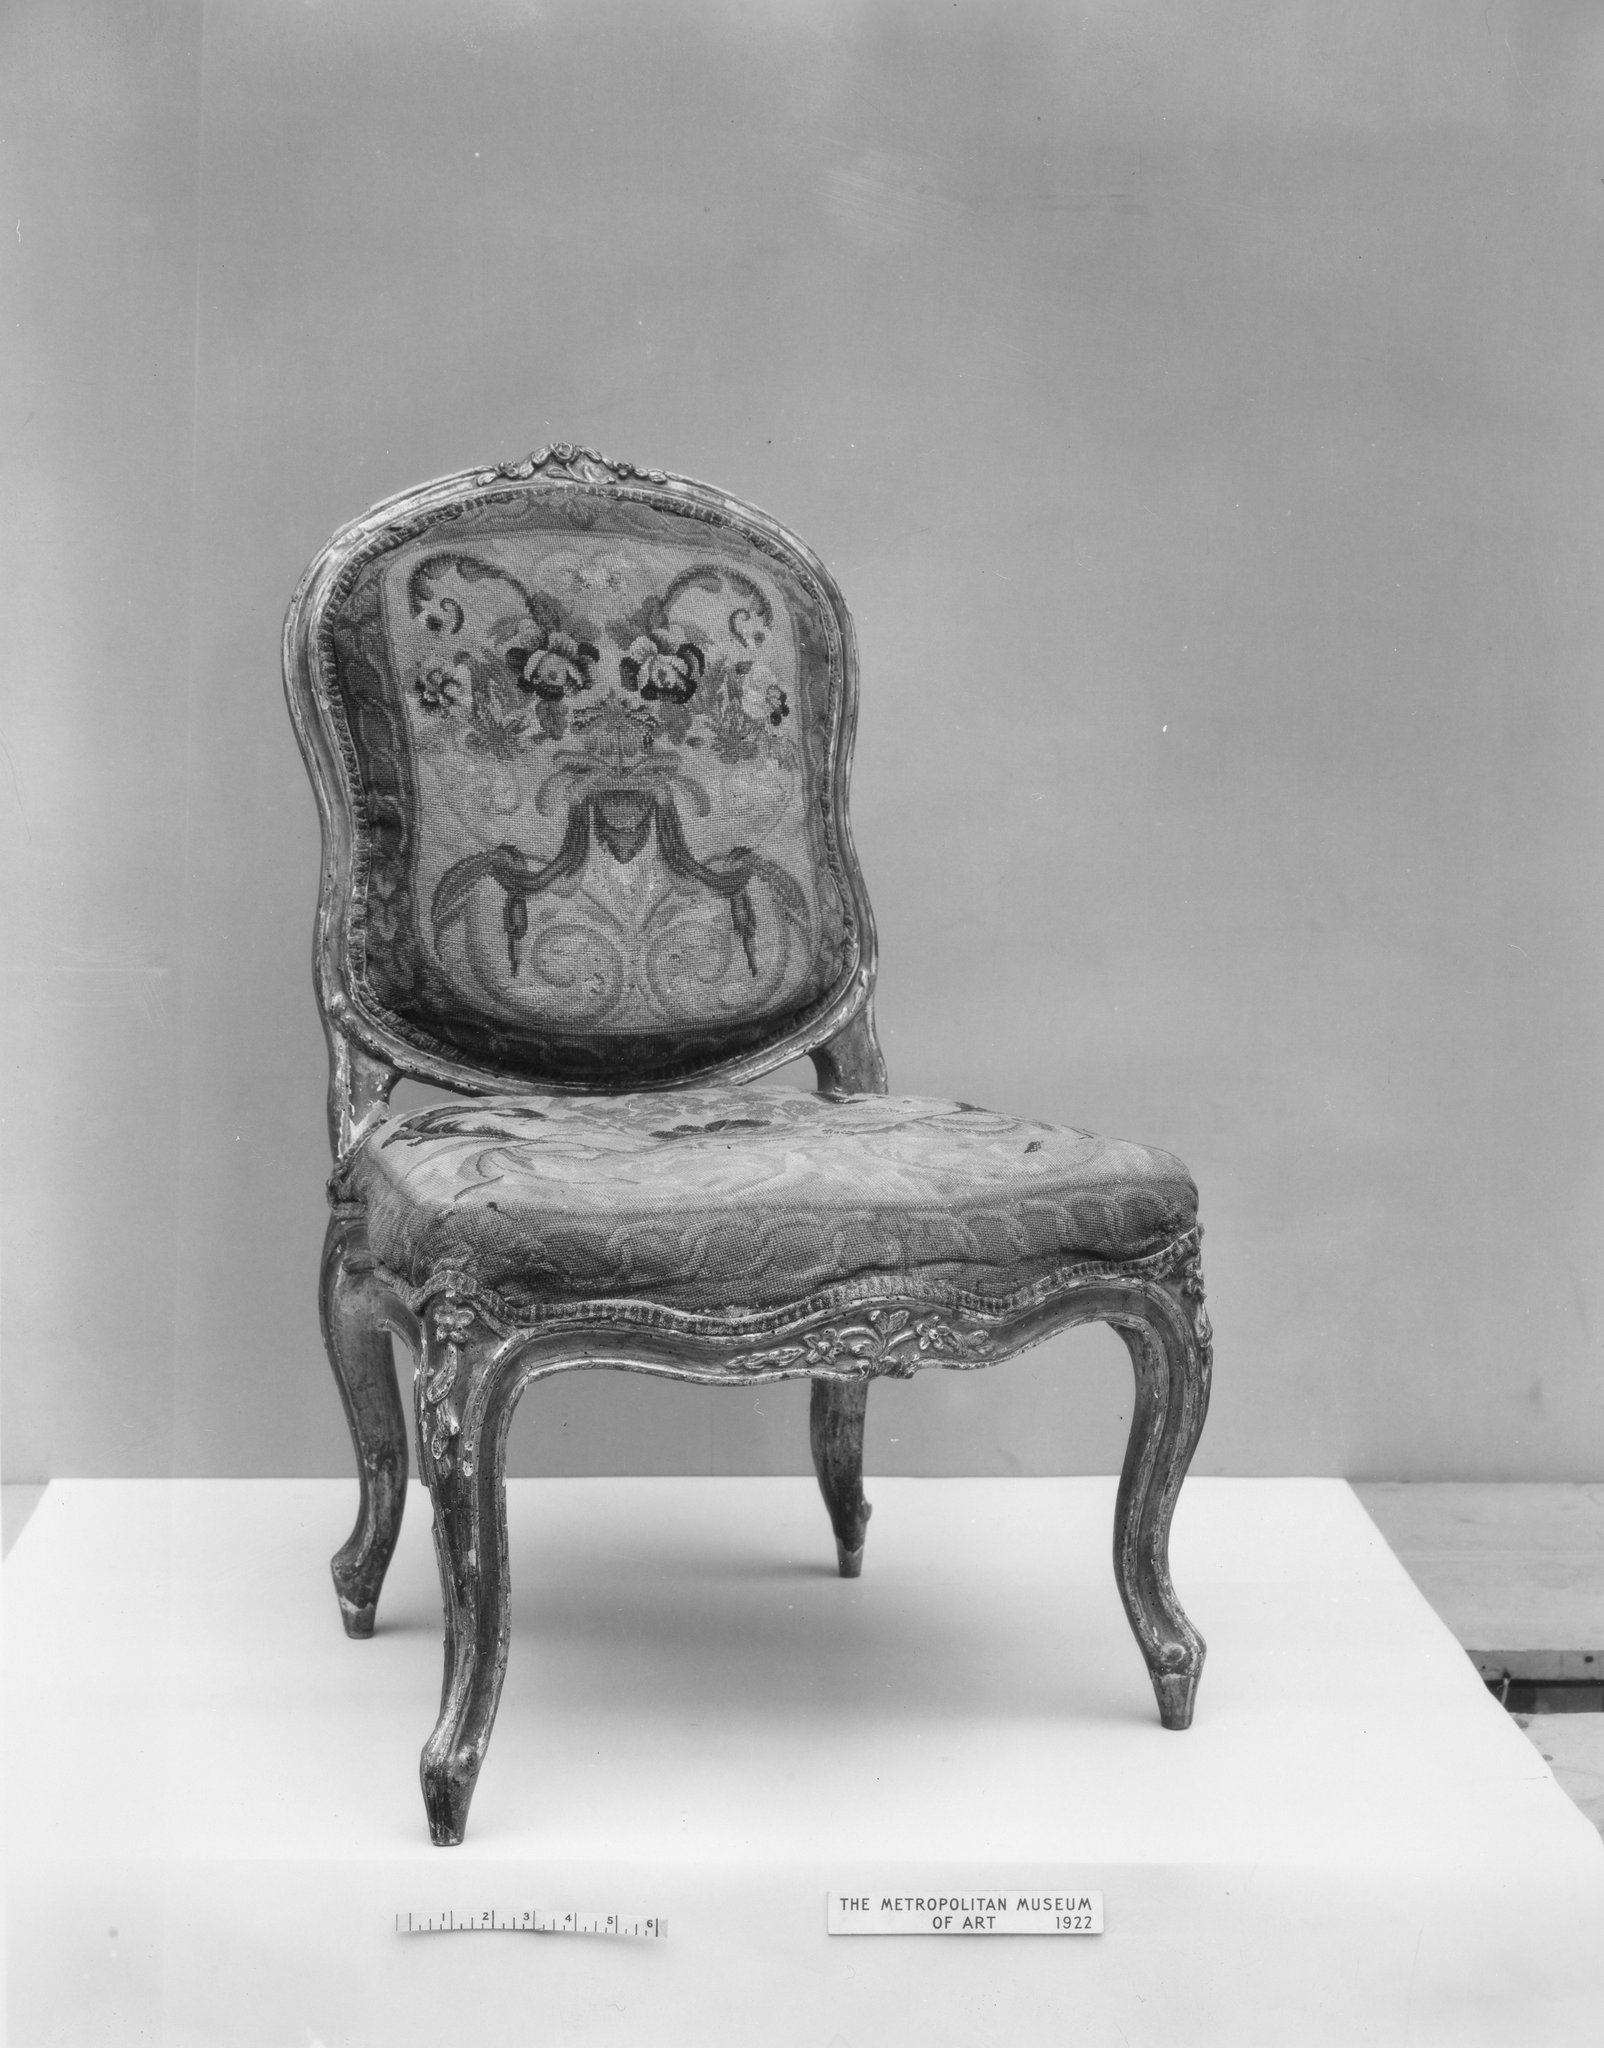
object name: side chair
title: Side chair (one of a pair, part of a set)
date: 1734-1766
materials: wood, wool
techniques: embroidery, painting, silvered